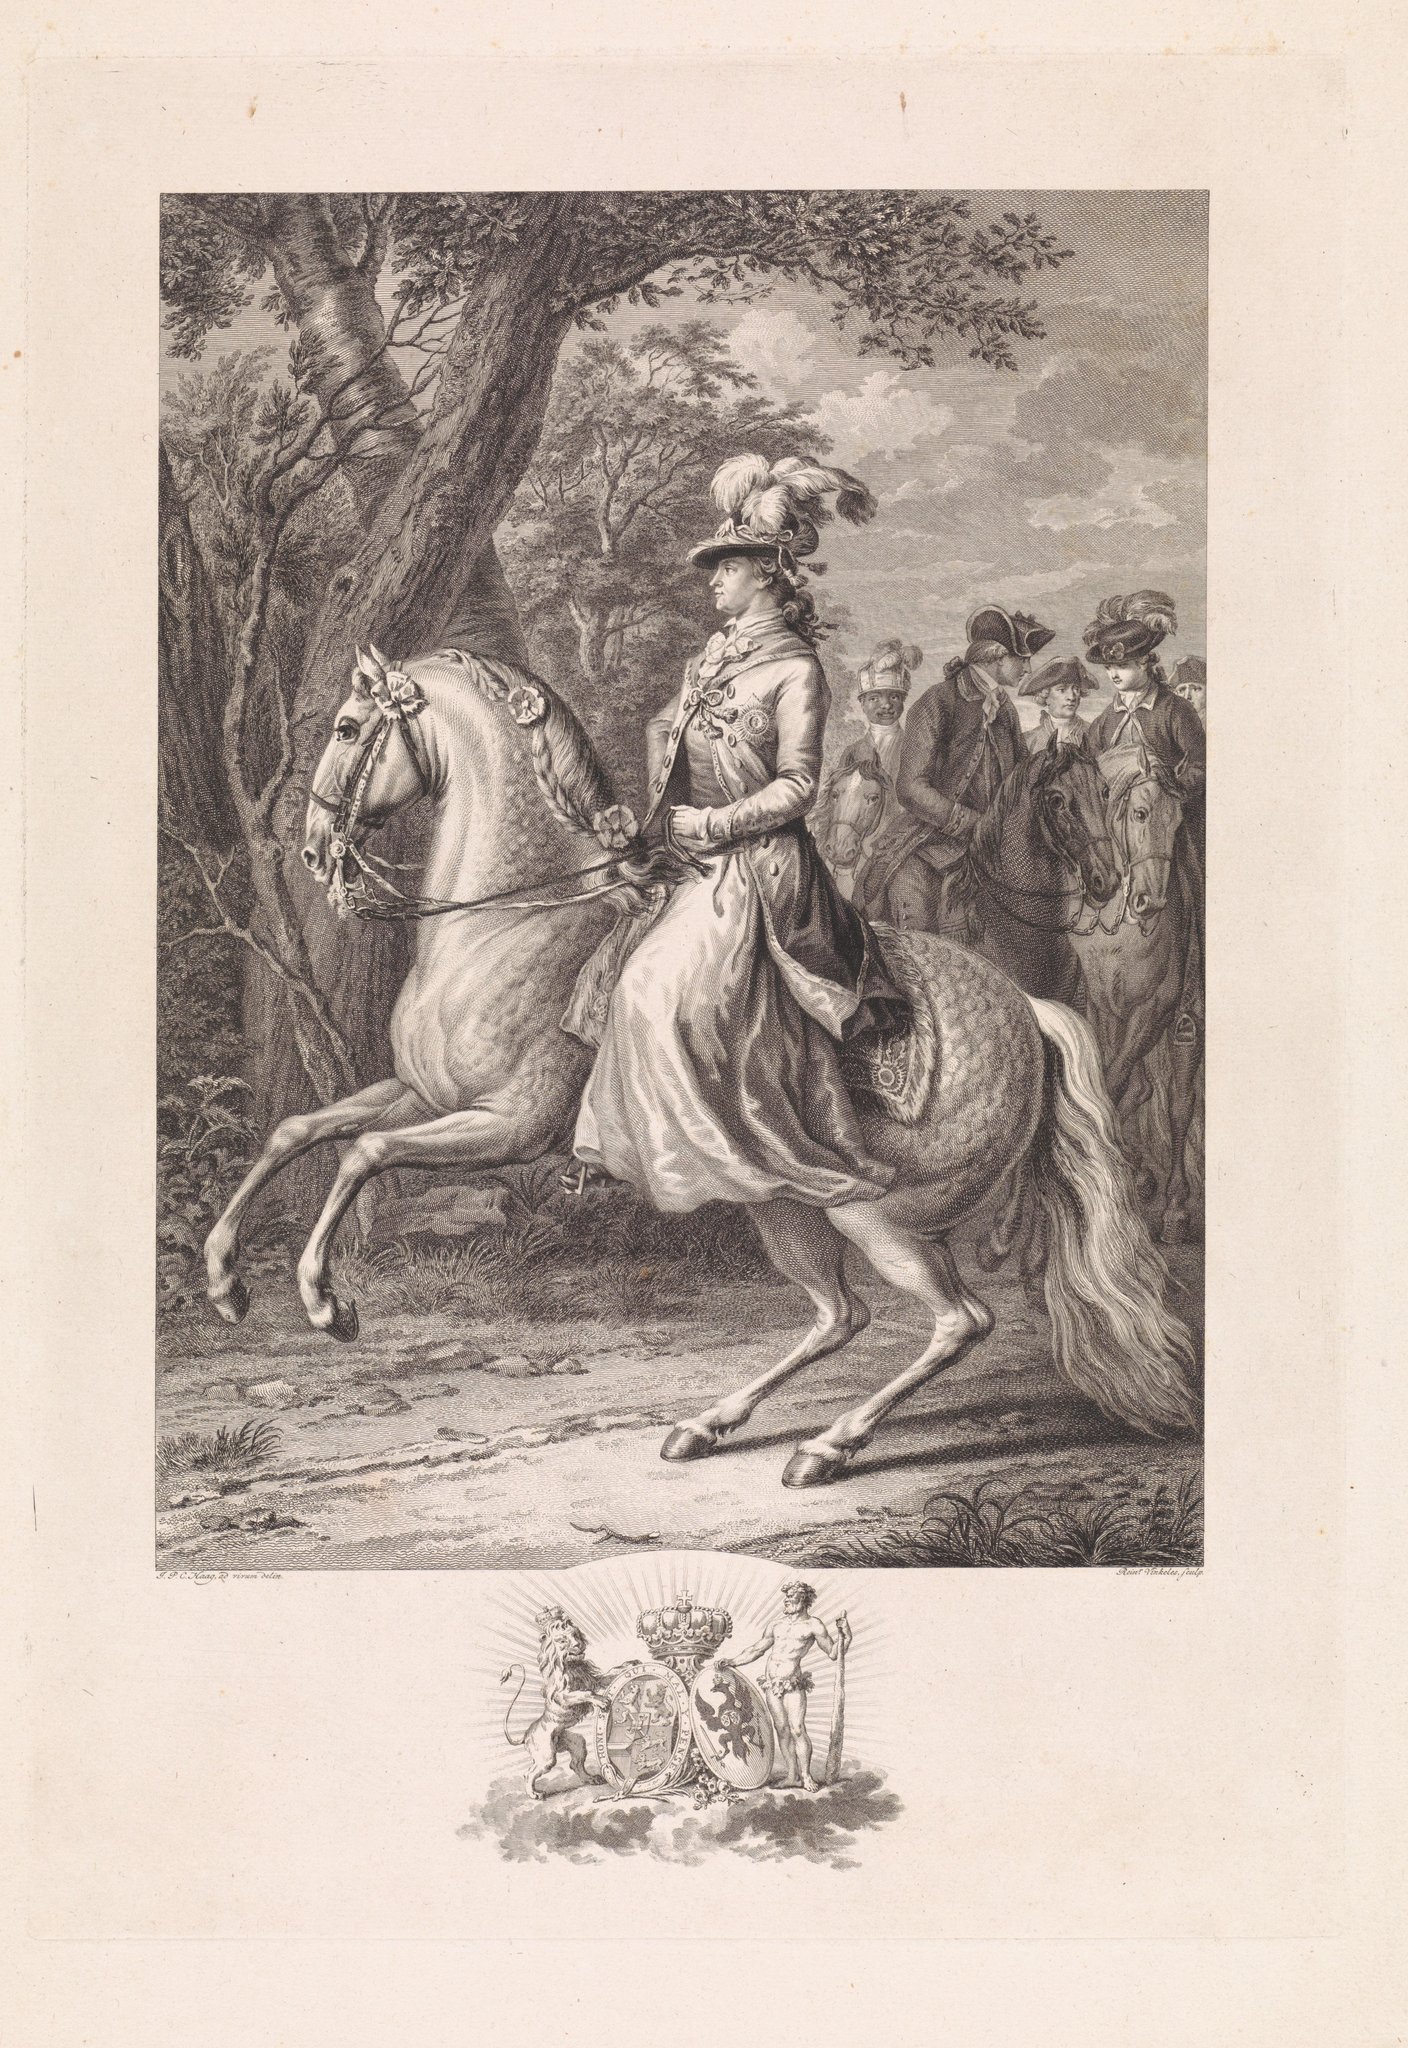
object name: print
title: Portret van Wilhelmina van Pruisen, te paard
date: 1779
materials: paper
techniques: engraving, etching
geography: amsterdam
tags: berlin, painter, draughtsman, wilhelmina of prussia (princess of orange), horse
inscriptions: collector's mark: Lugt 2228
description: Portret van Wilhelmina van Pruisen, te paard in een landschap. Achter haar haar gevolg.